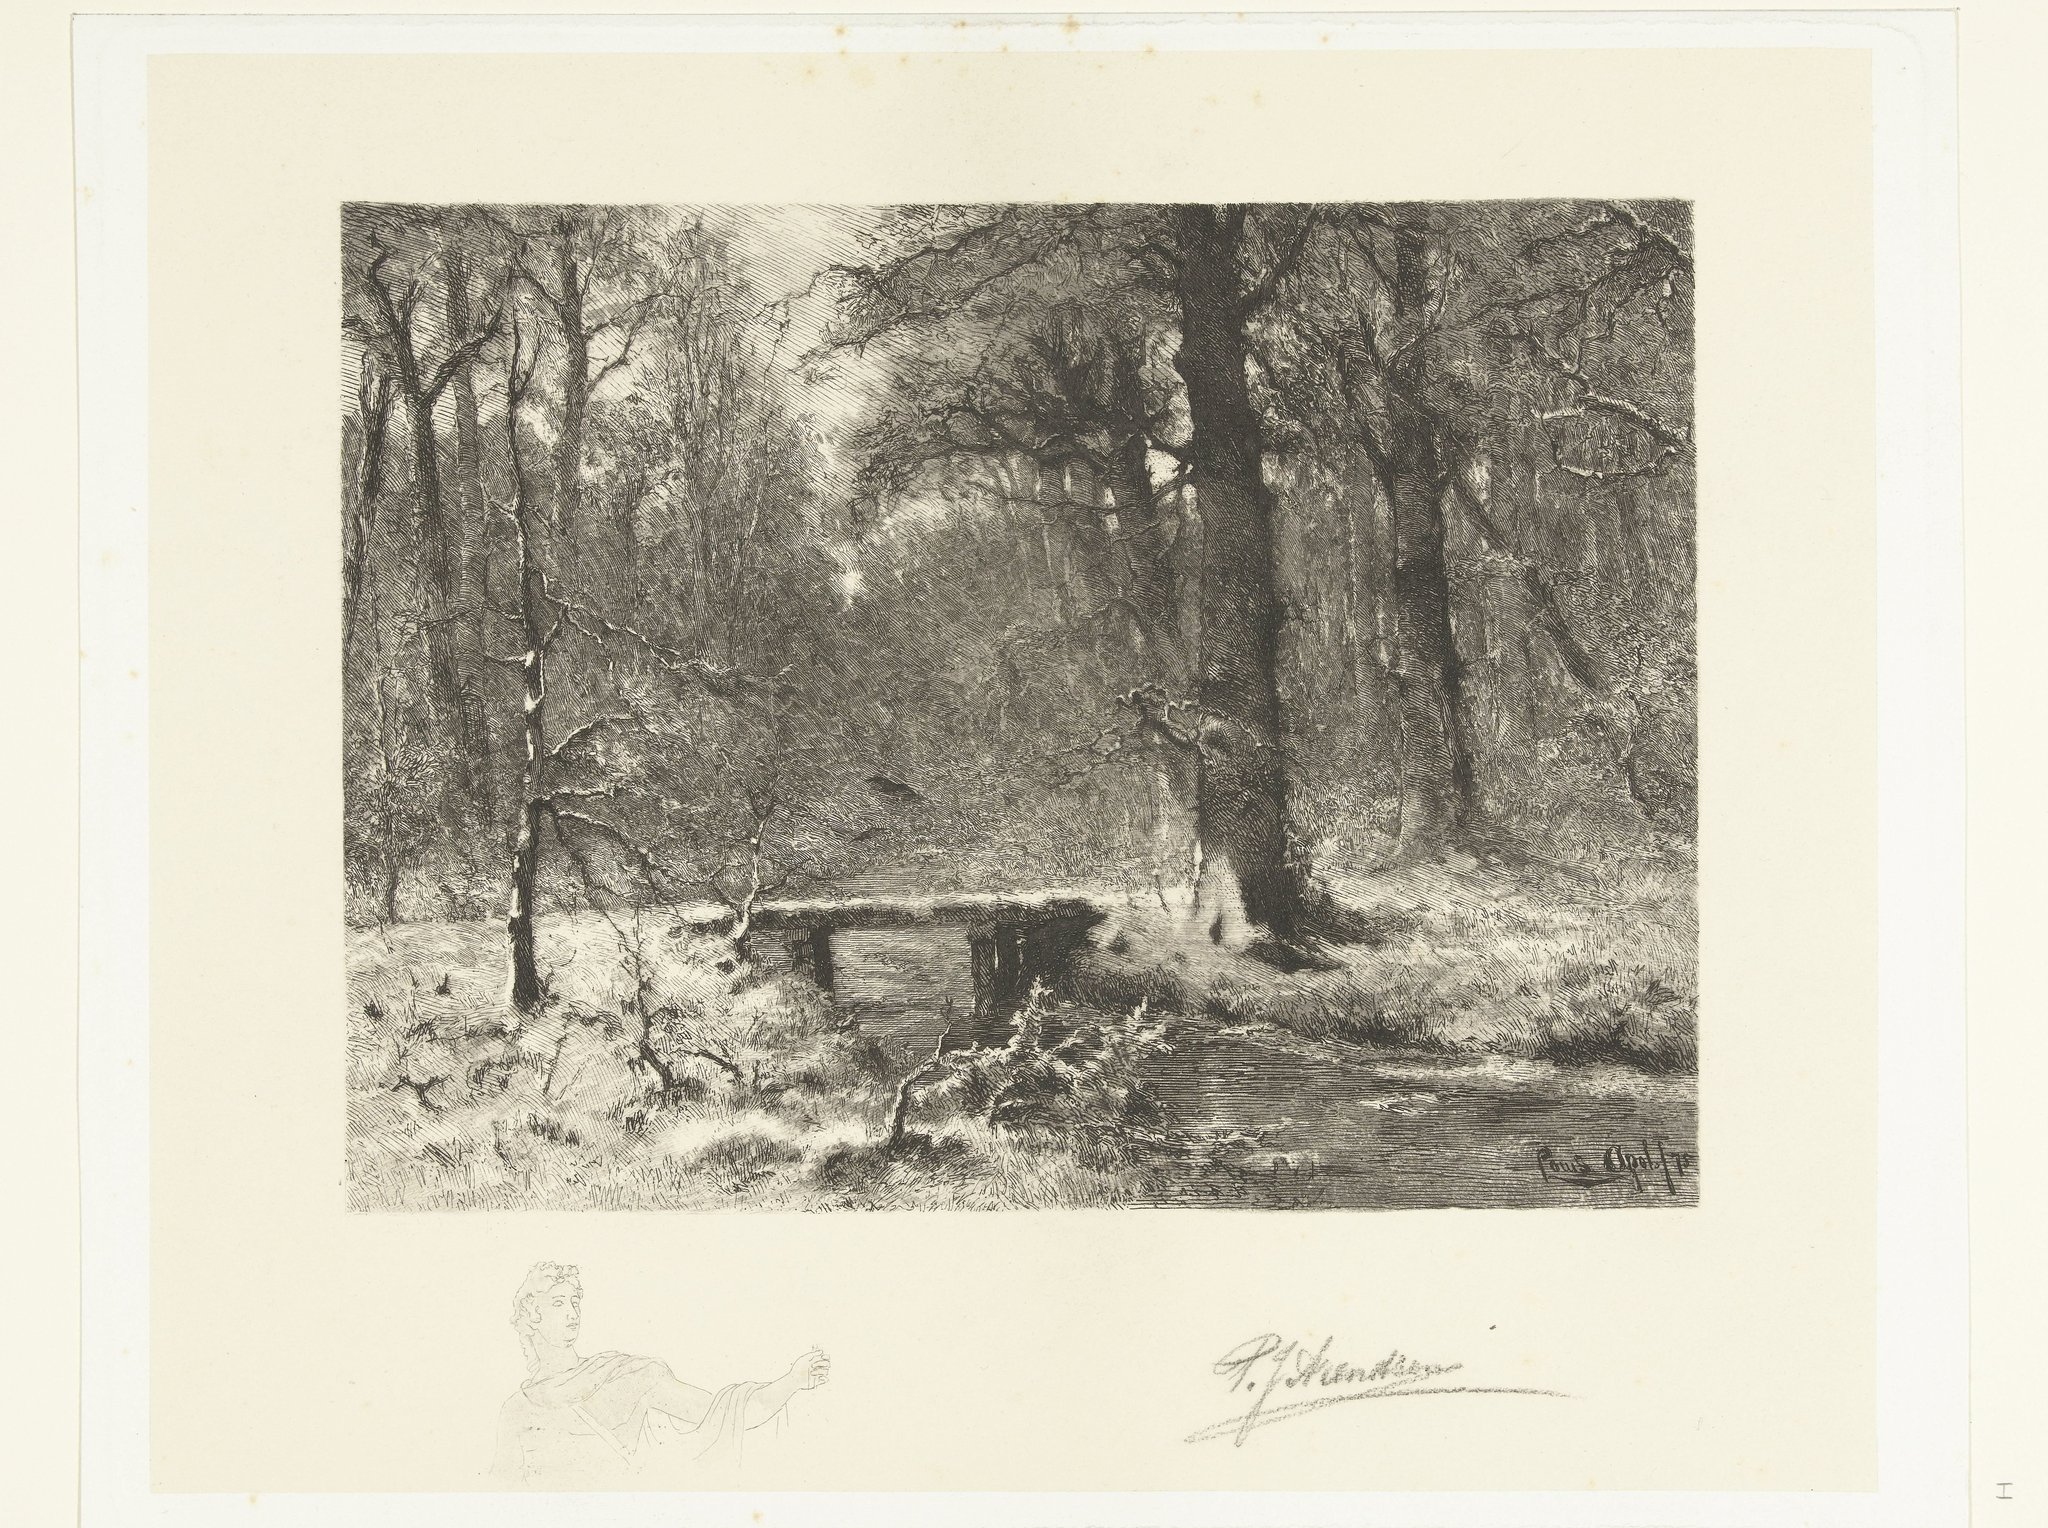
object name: print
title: Wintergezicht in het Haagse bos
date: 1865-1879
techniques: printmaking, etching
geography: netherlands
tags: forest, wood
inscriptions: collector's mark: Lugt 2228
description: Wintergezicht in het Haagse bos. In marge een schets van de Apollo Belvedere.